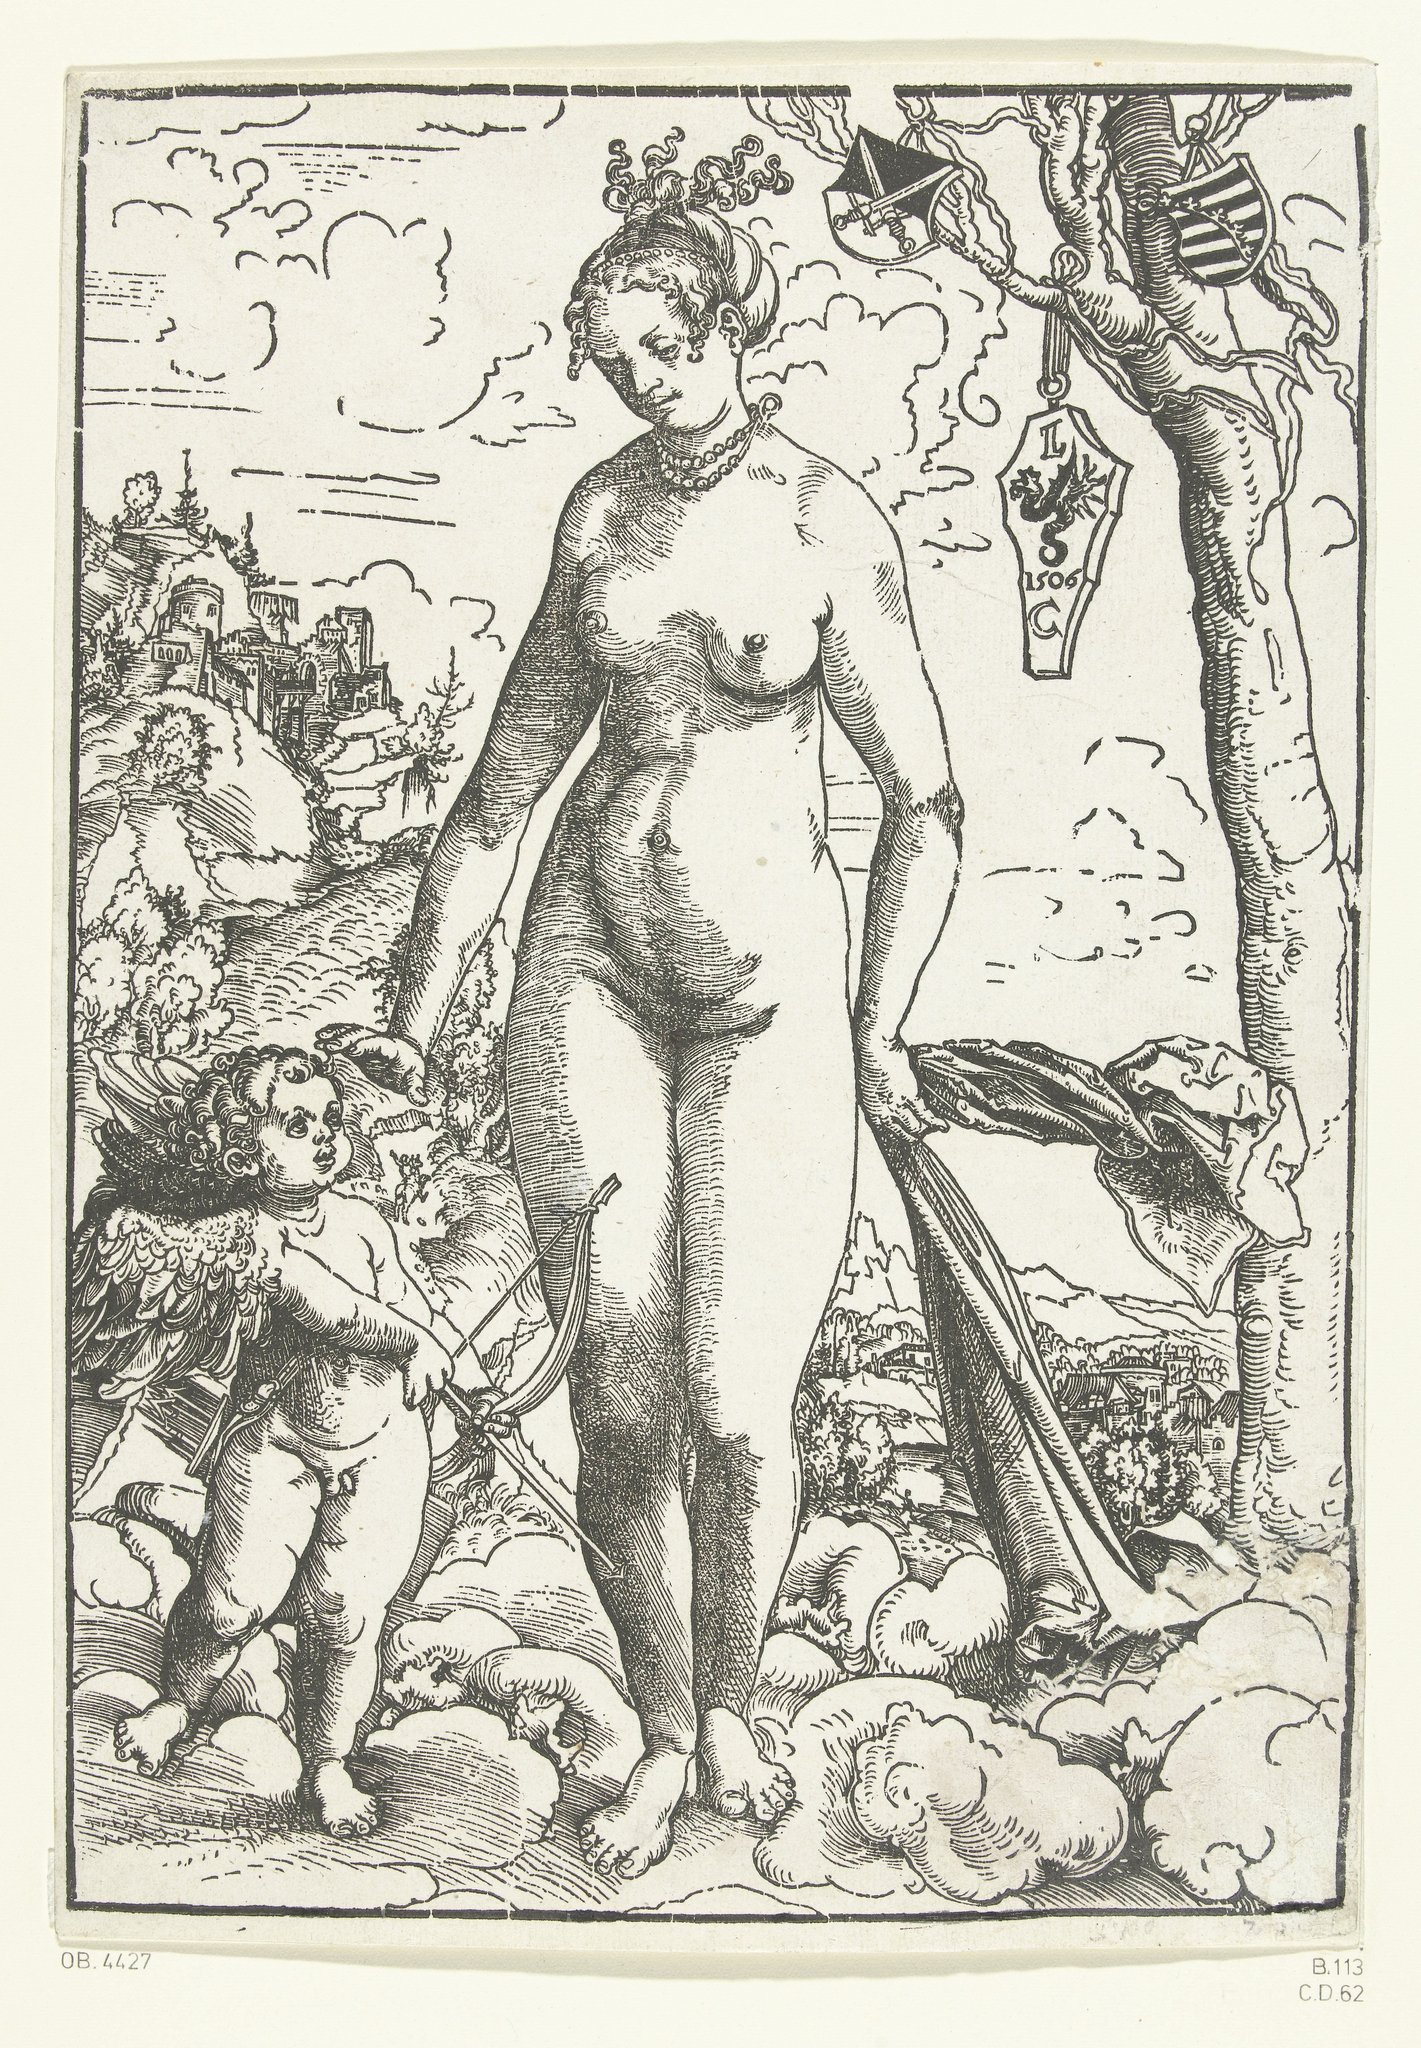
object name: print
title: Venus en Amor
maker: lucas cranach (i)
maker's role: draughtsman, print maker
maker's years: 1472-1553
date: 1506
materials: paper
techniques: woodcut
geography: germany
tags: venus and cupid (cupid not being mere attribute)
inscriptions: collector's mark: Lugt 240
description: Naakte Venus in gezelschap van Amor die pijl en boog vasthoudt. In de boom rechts hangen drie schilden, twee met het keurvorstelijk en hertogelijk wapen van Saksen en een derde met het wapen van Cranach zelf.